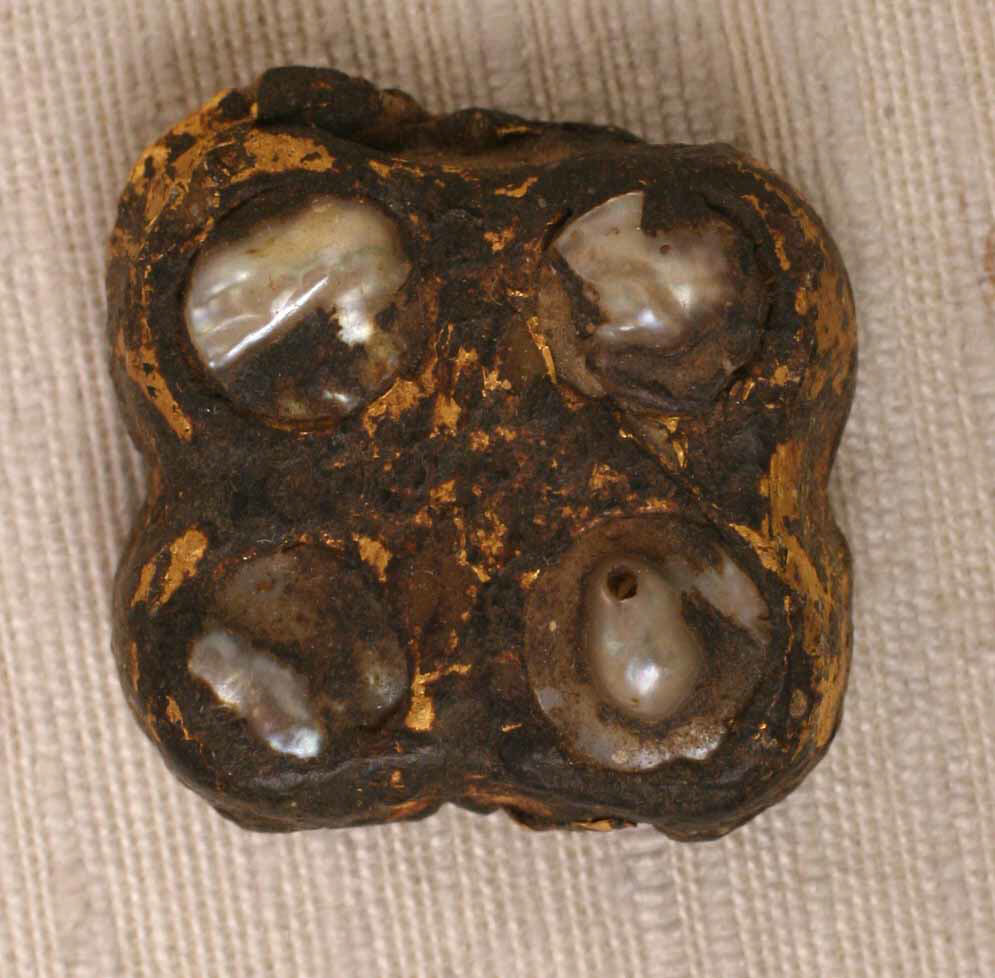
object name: plaque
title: Plaque for a Collar or Necklace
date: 701-800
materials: gold, mother of pearl, stone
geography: egypt